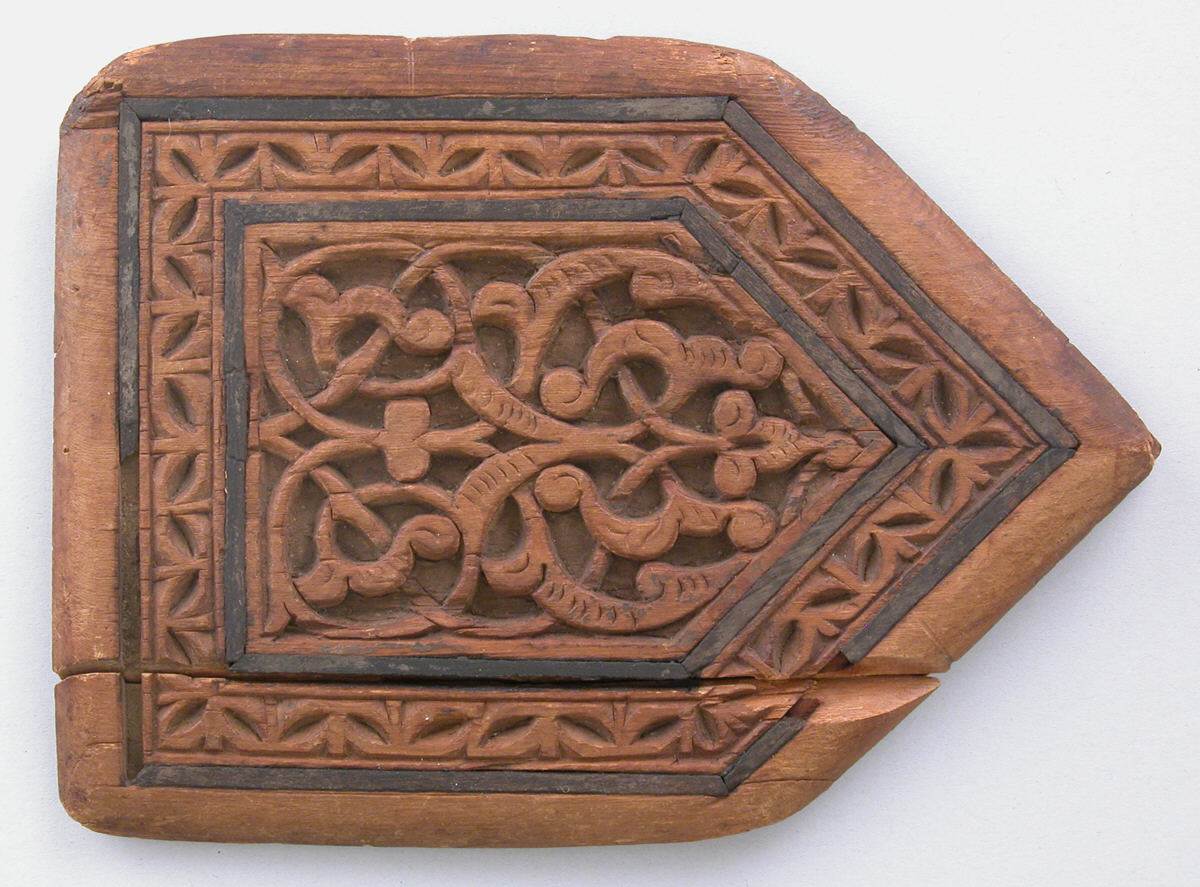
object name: panel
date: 1201-1400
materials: wood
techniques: carving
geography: egypt